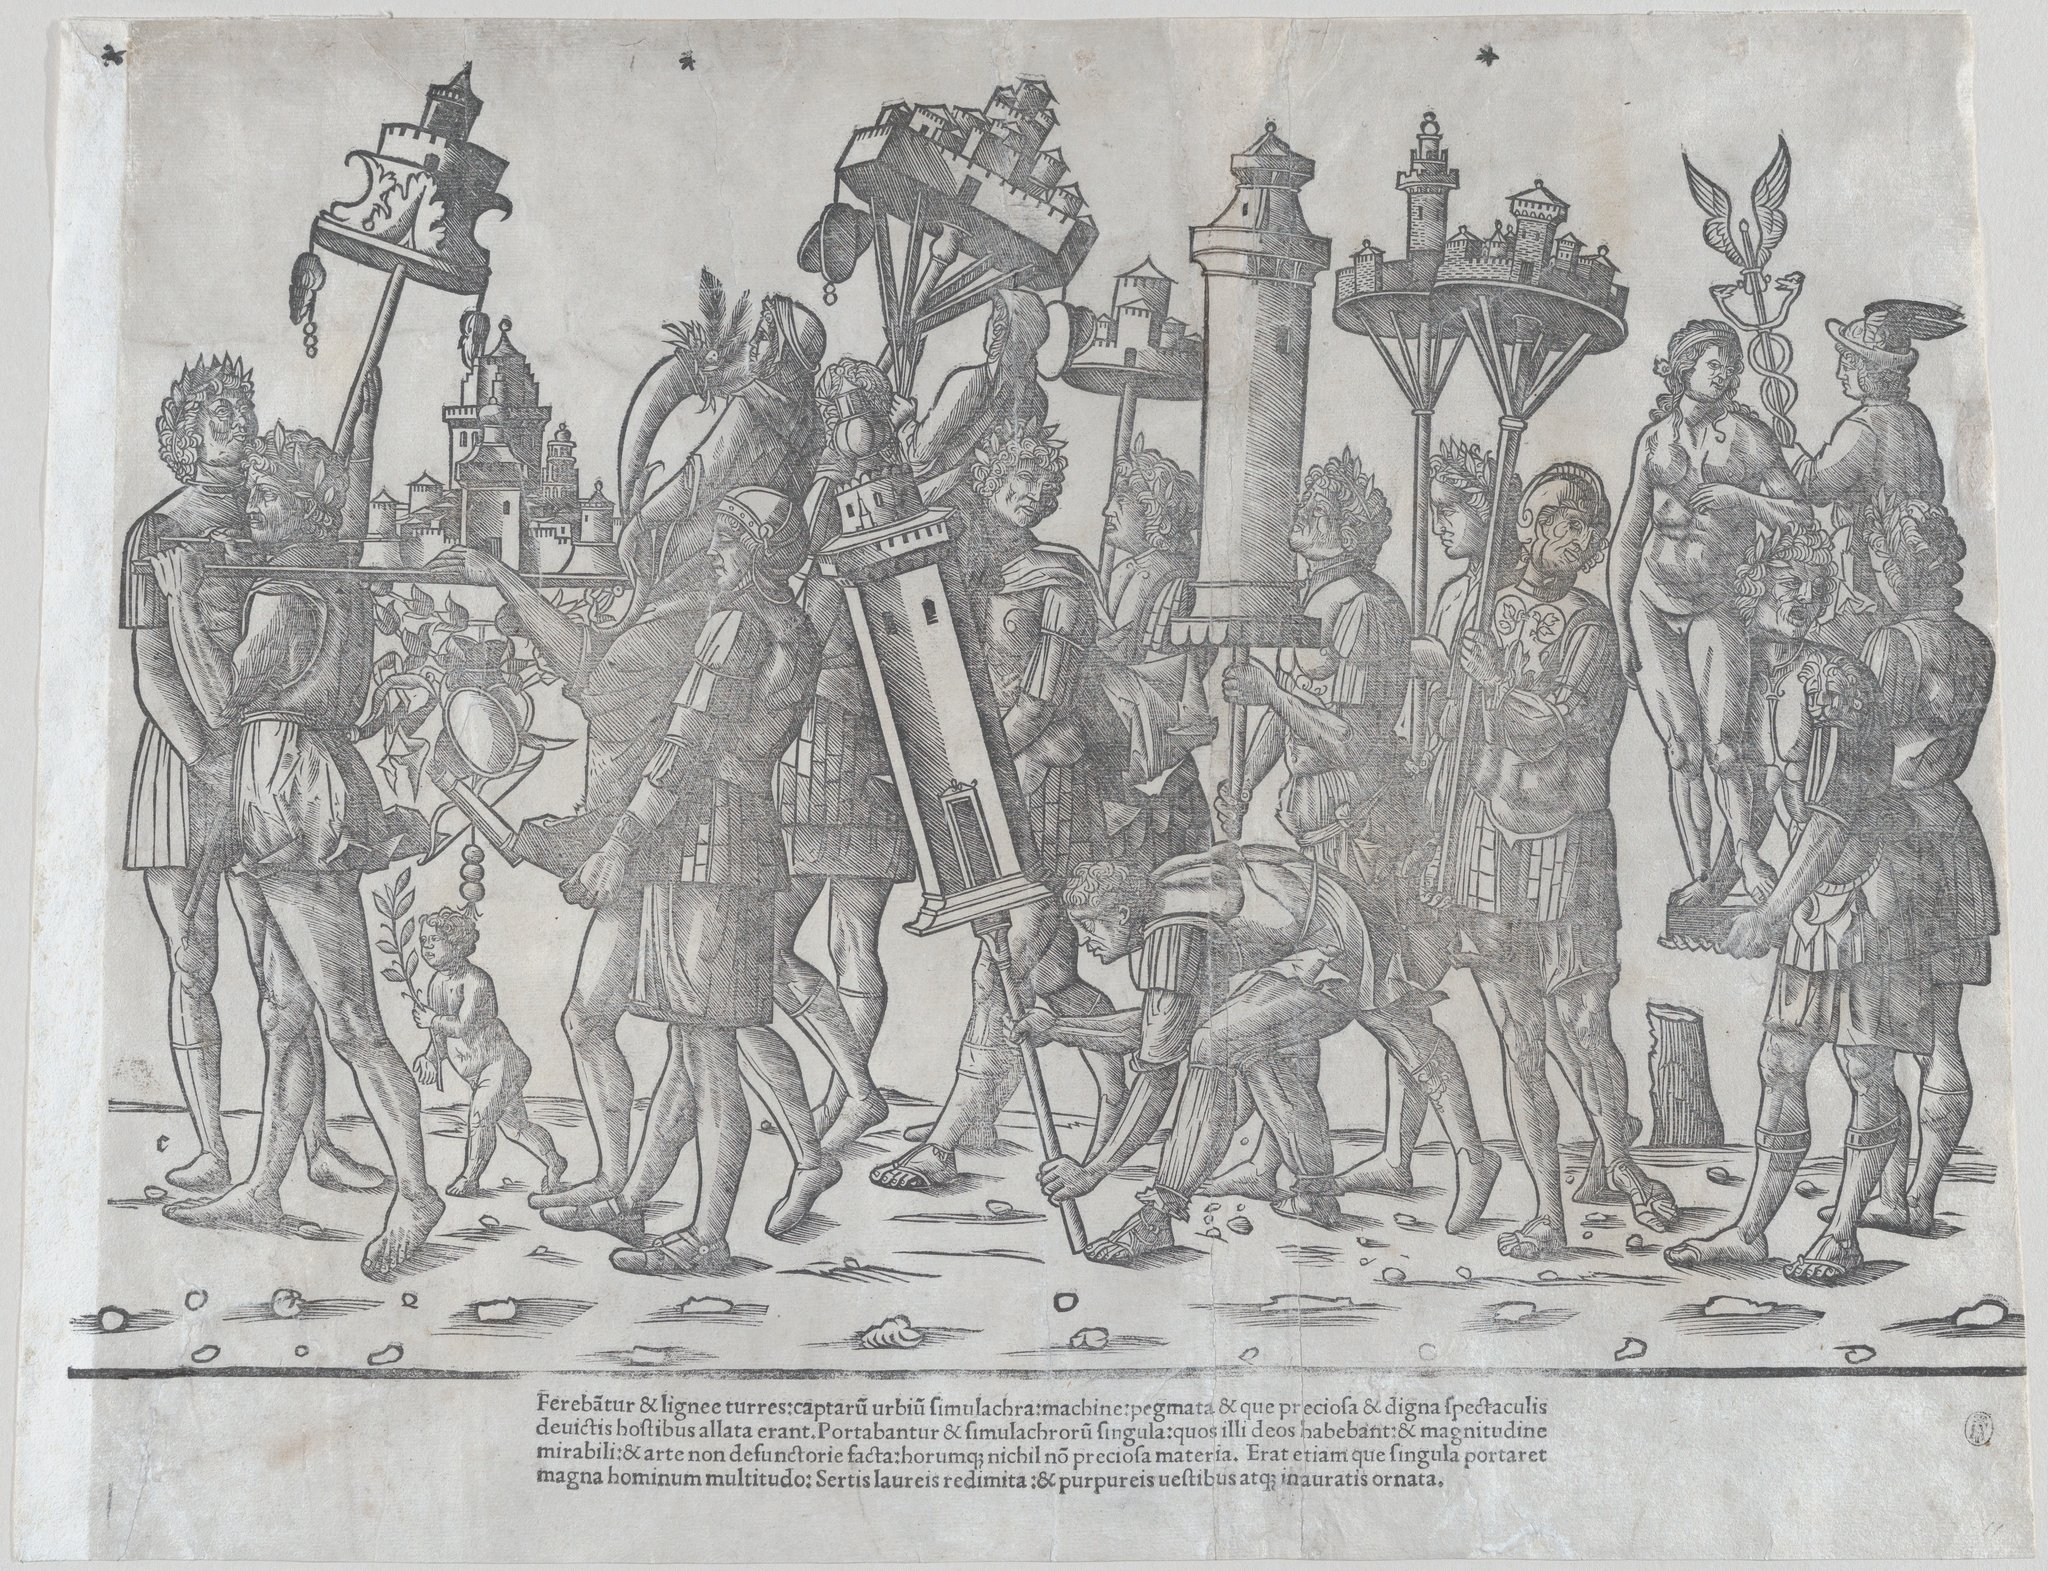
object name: print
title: Statues of Venus and Mercury, from "The Triumph of Caesar"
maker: jacob of strasbourg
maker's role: artist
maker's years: 1494-1530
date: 1503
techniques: woodcut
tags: soldiers,mercury,venus